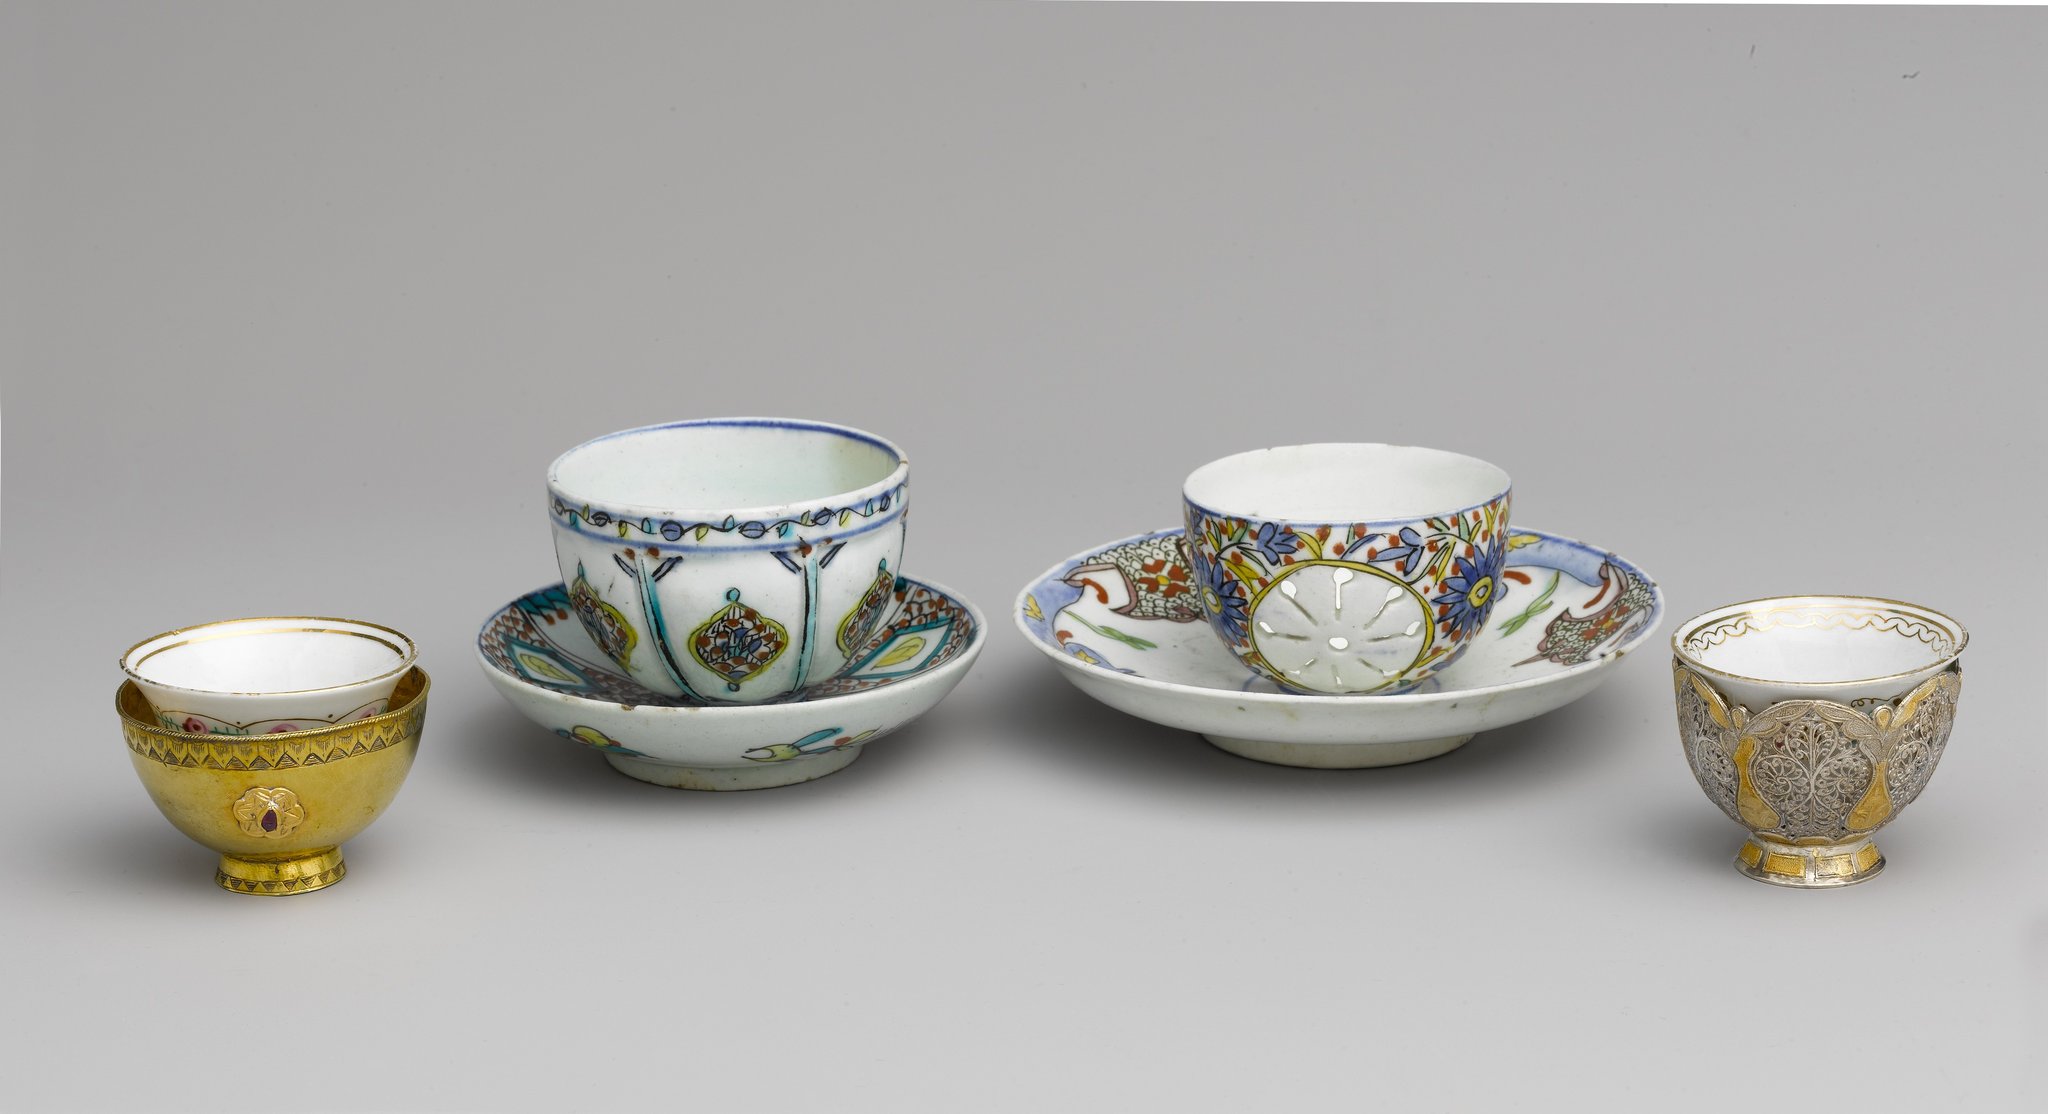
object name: cup and saucer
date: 1701-1800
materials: glaze, stonepaste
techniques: painting, polychrome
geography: turkey